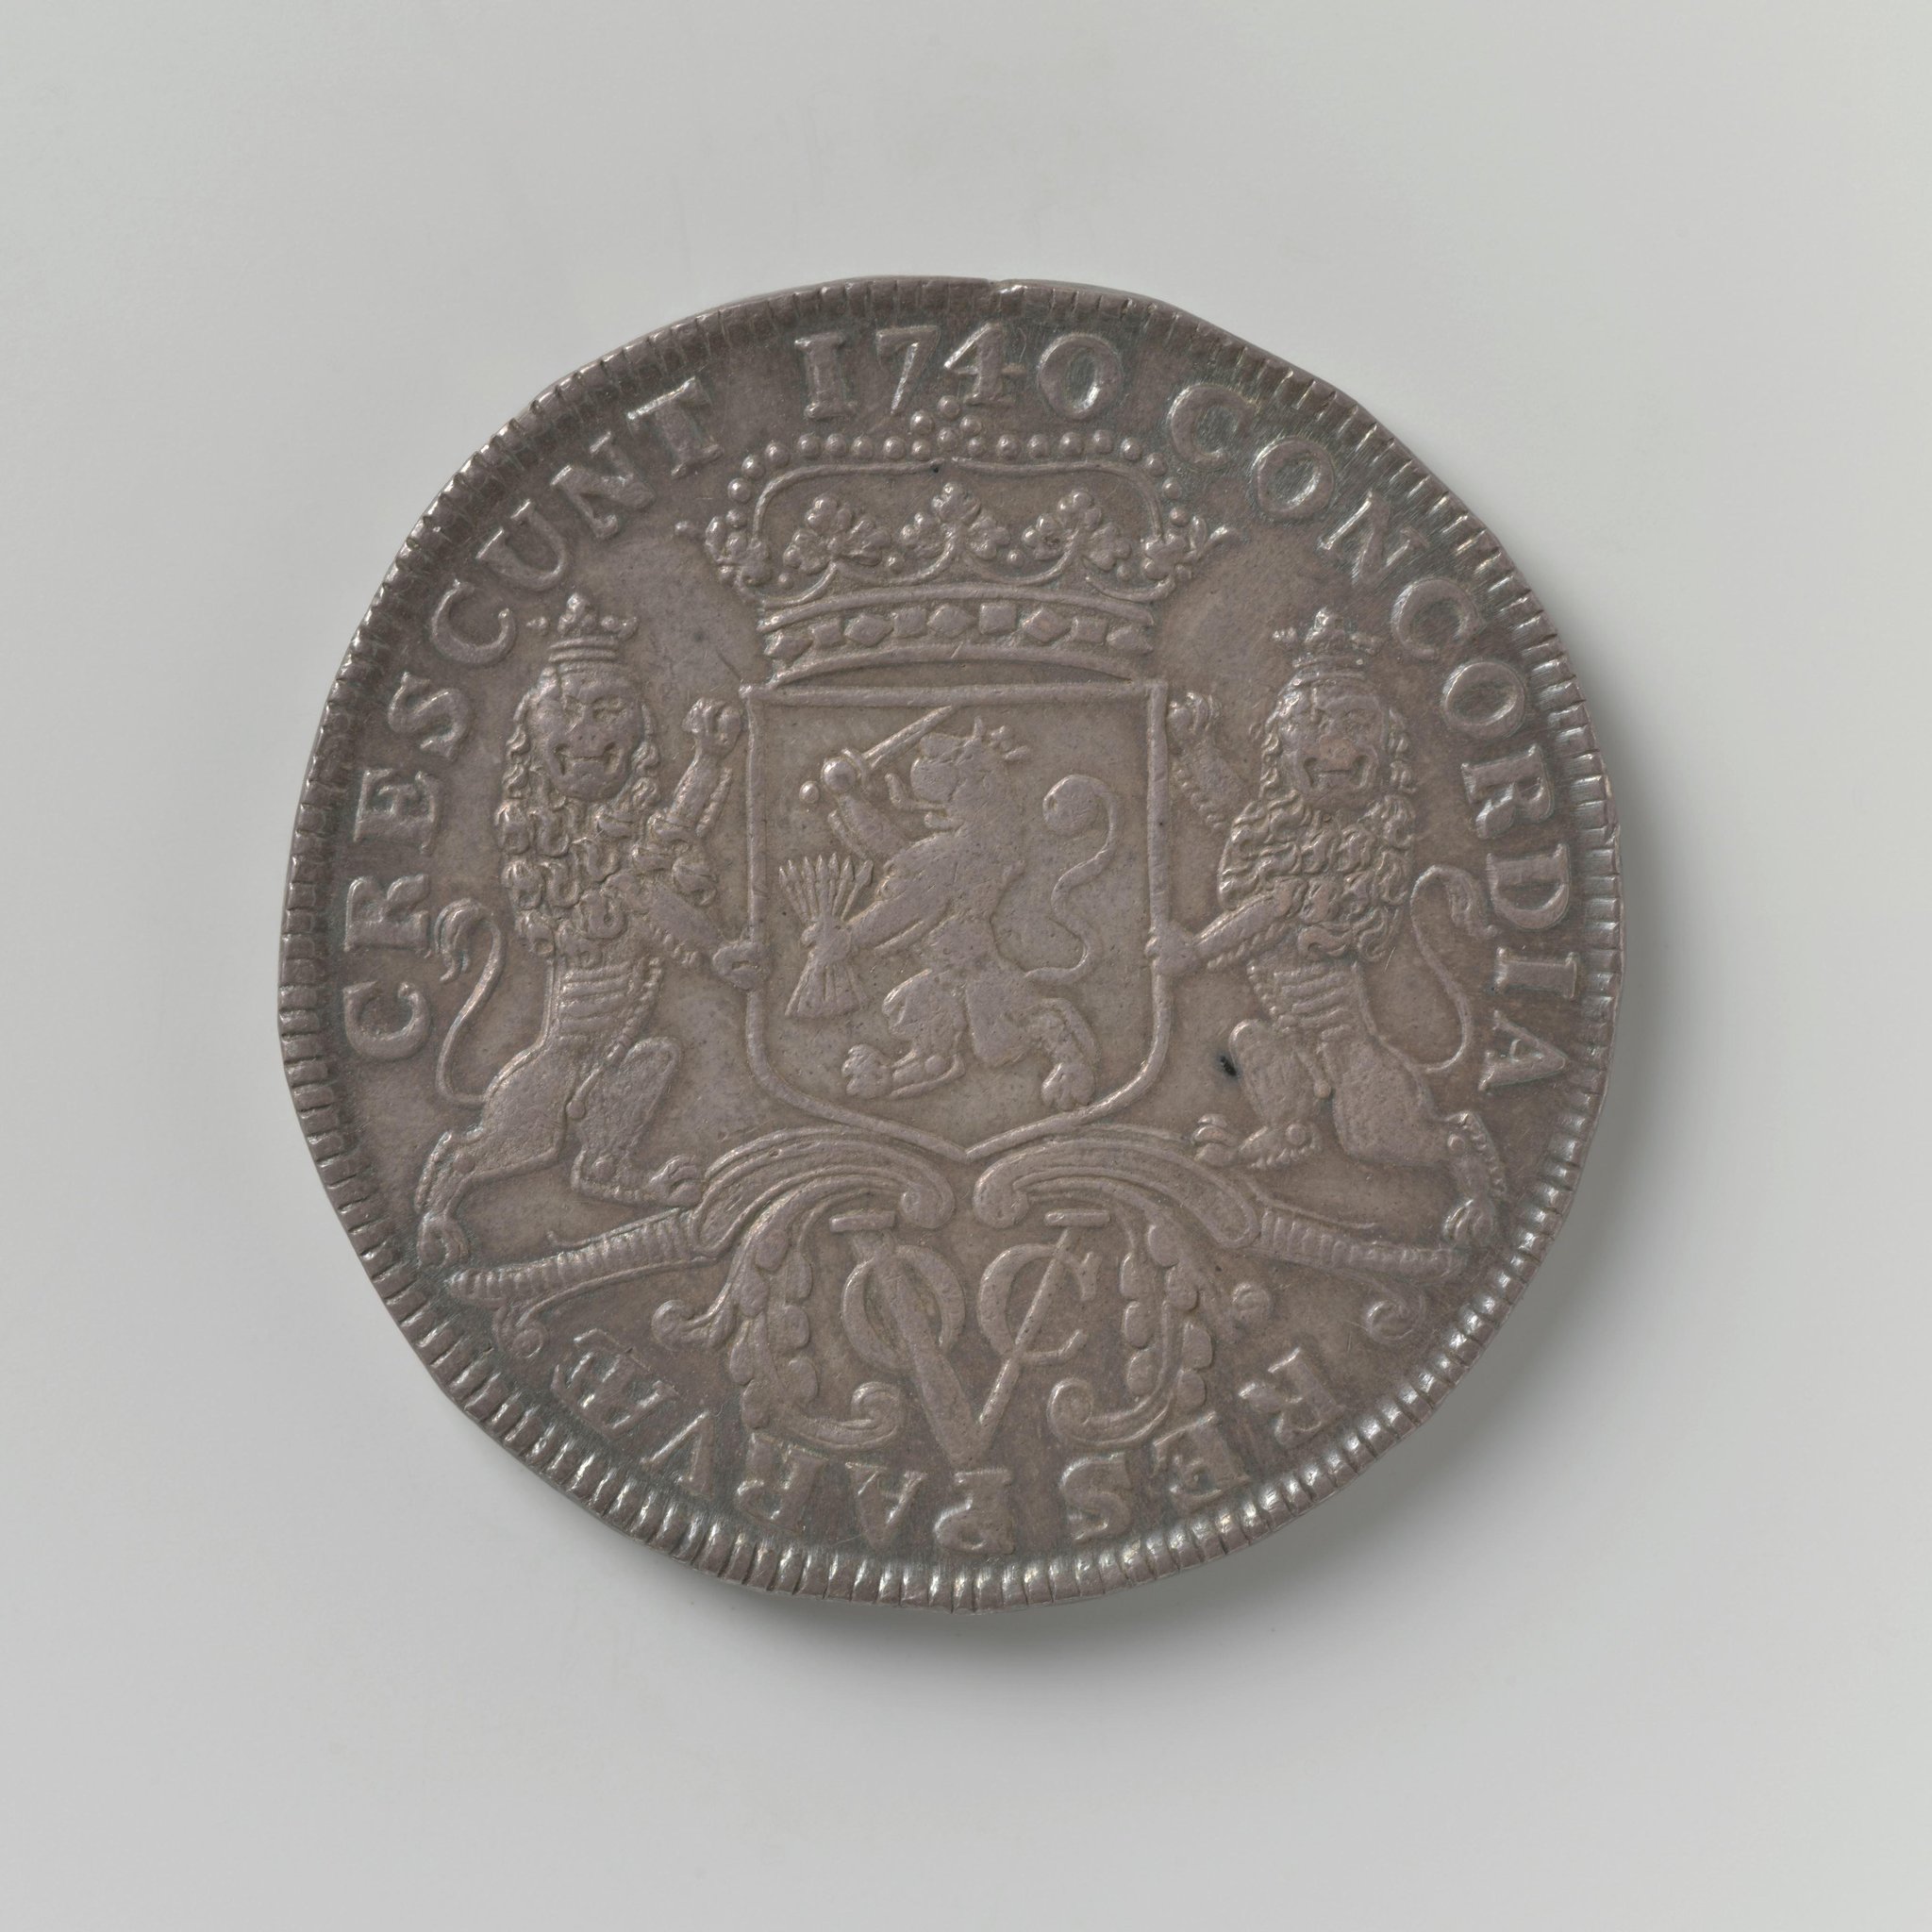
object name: coin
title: Zilveren rijder van de VOC uit West-Friesland, 1740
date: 1740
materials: silver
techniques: striking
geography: enkhuizen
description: Zilveren munt. Voorzijde: geharnaste ridder met zwaard te paard naar links, waaronder gekroond wapenschild van Westfriesland. Keerzijde: gekroond generaliteitswapenschild, waaronder cartouche, waarin monogram van de VOC. Jaartal in omschrift, boven kroon. Gladde rand.